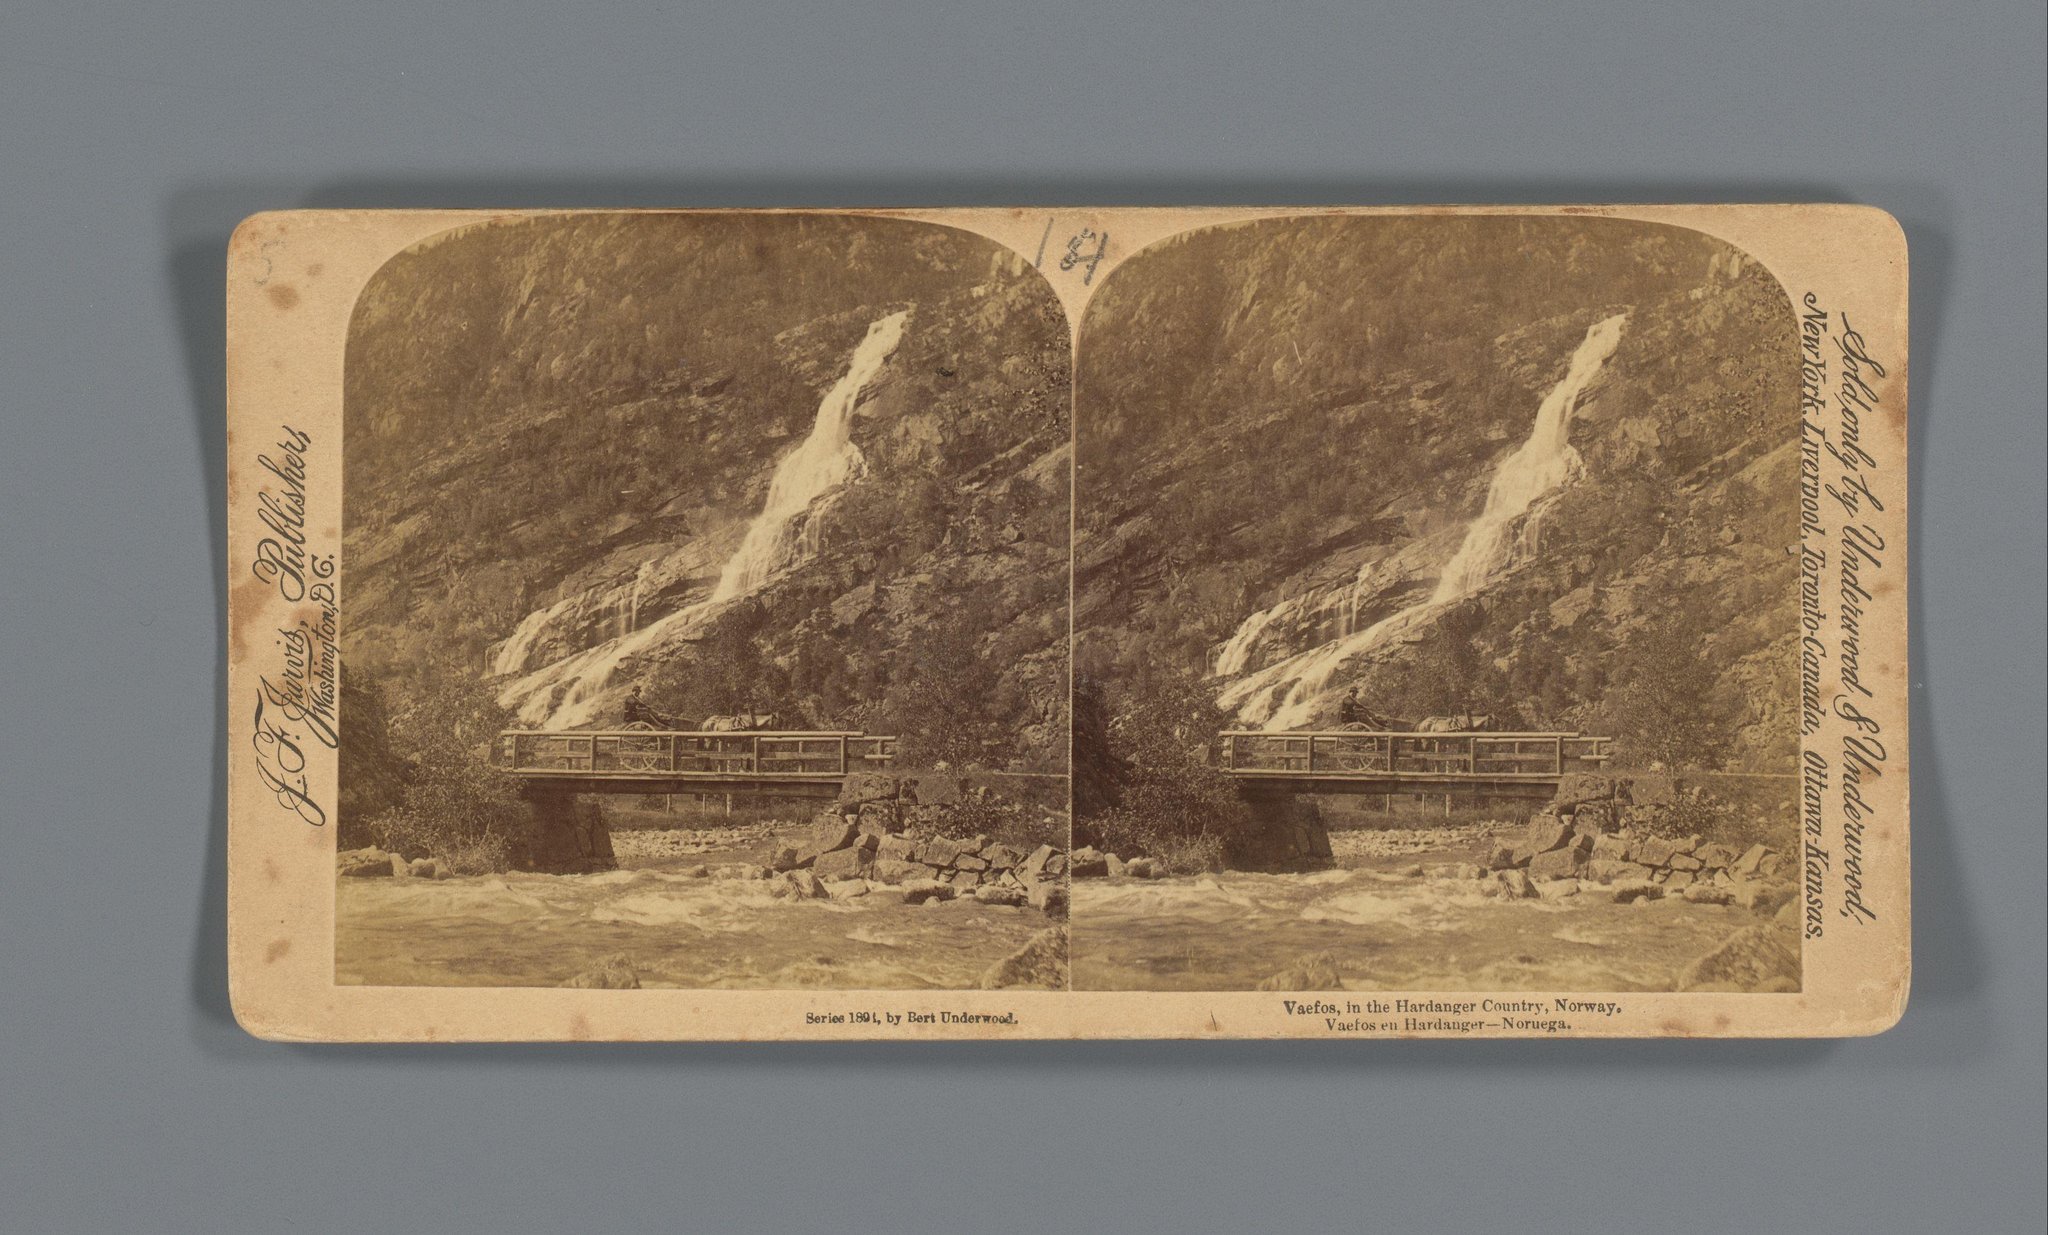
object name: stereograph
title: Vaefos, in the Hardanger Country, Norway. /Vaefos en Hardanger - Noruega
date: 1891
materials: cardboard, paper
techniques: albumen print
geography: washington d.c.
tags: waterfall, bridge, two-wheeled vehicle drawn by one animal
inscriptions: number: ‘157’, inscription: ‘Sold only by Underwood & Underwood./ New York, Liverpool, Toronto-Canada, Ottawa-Kansas.’